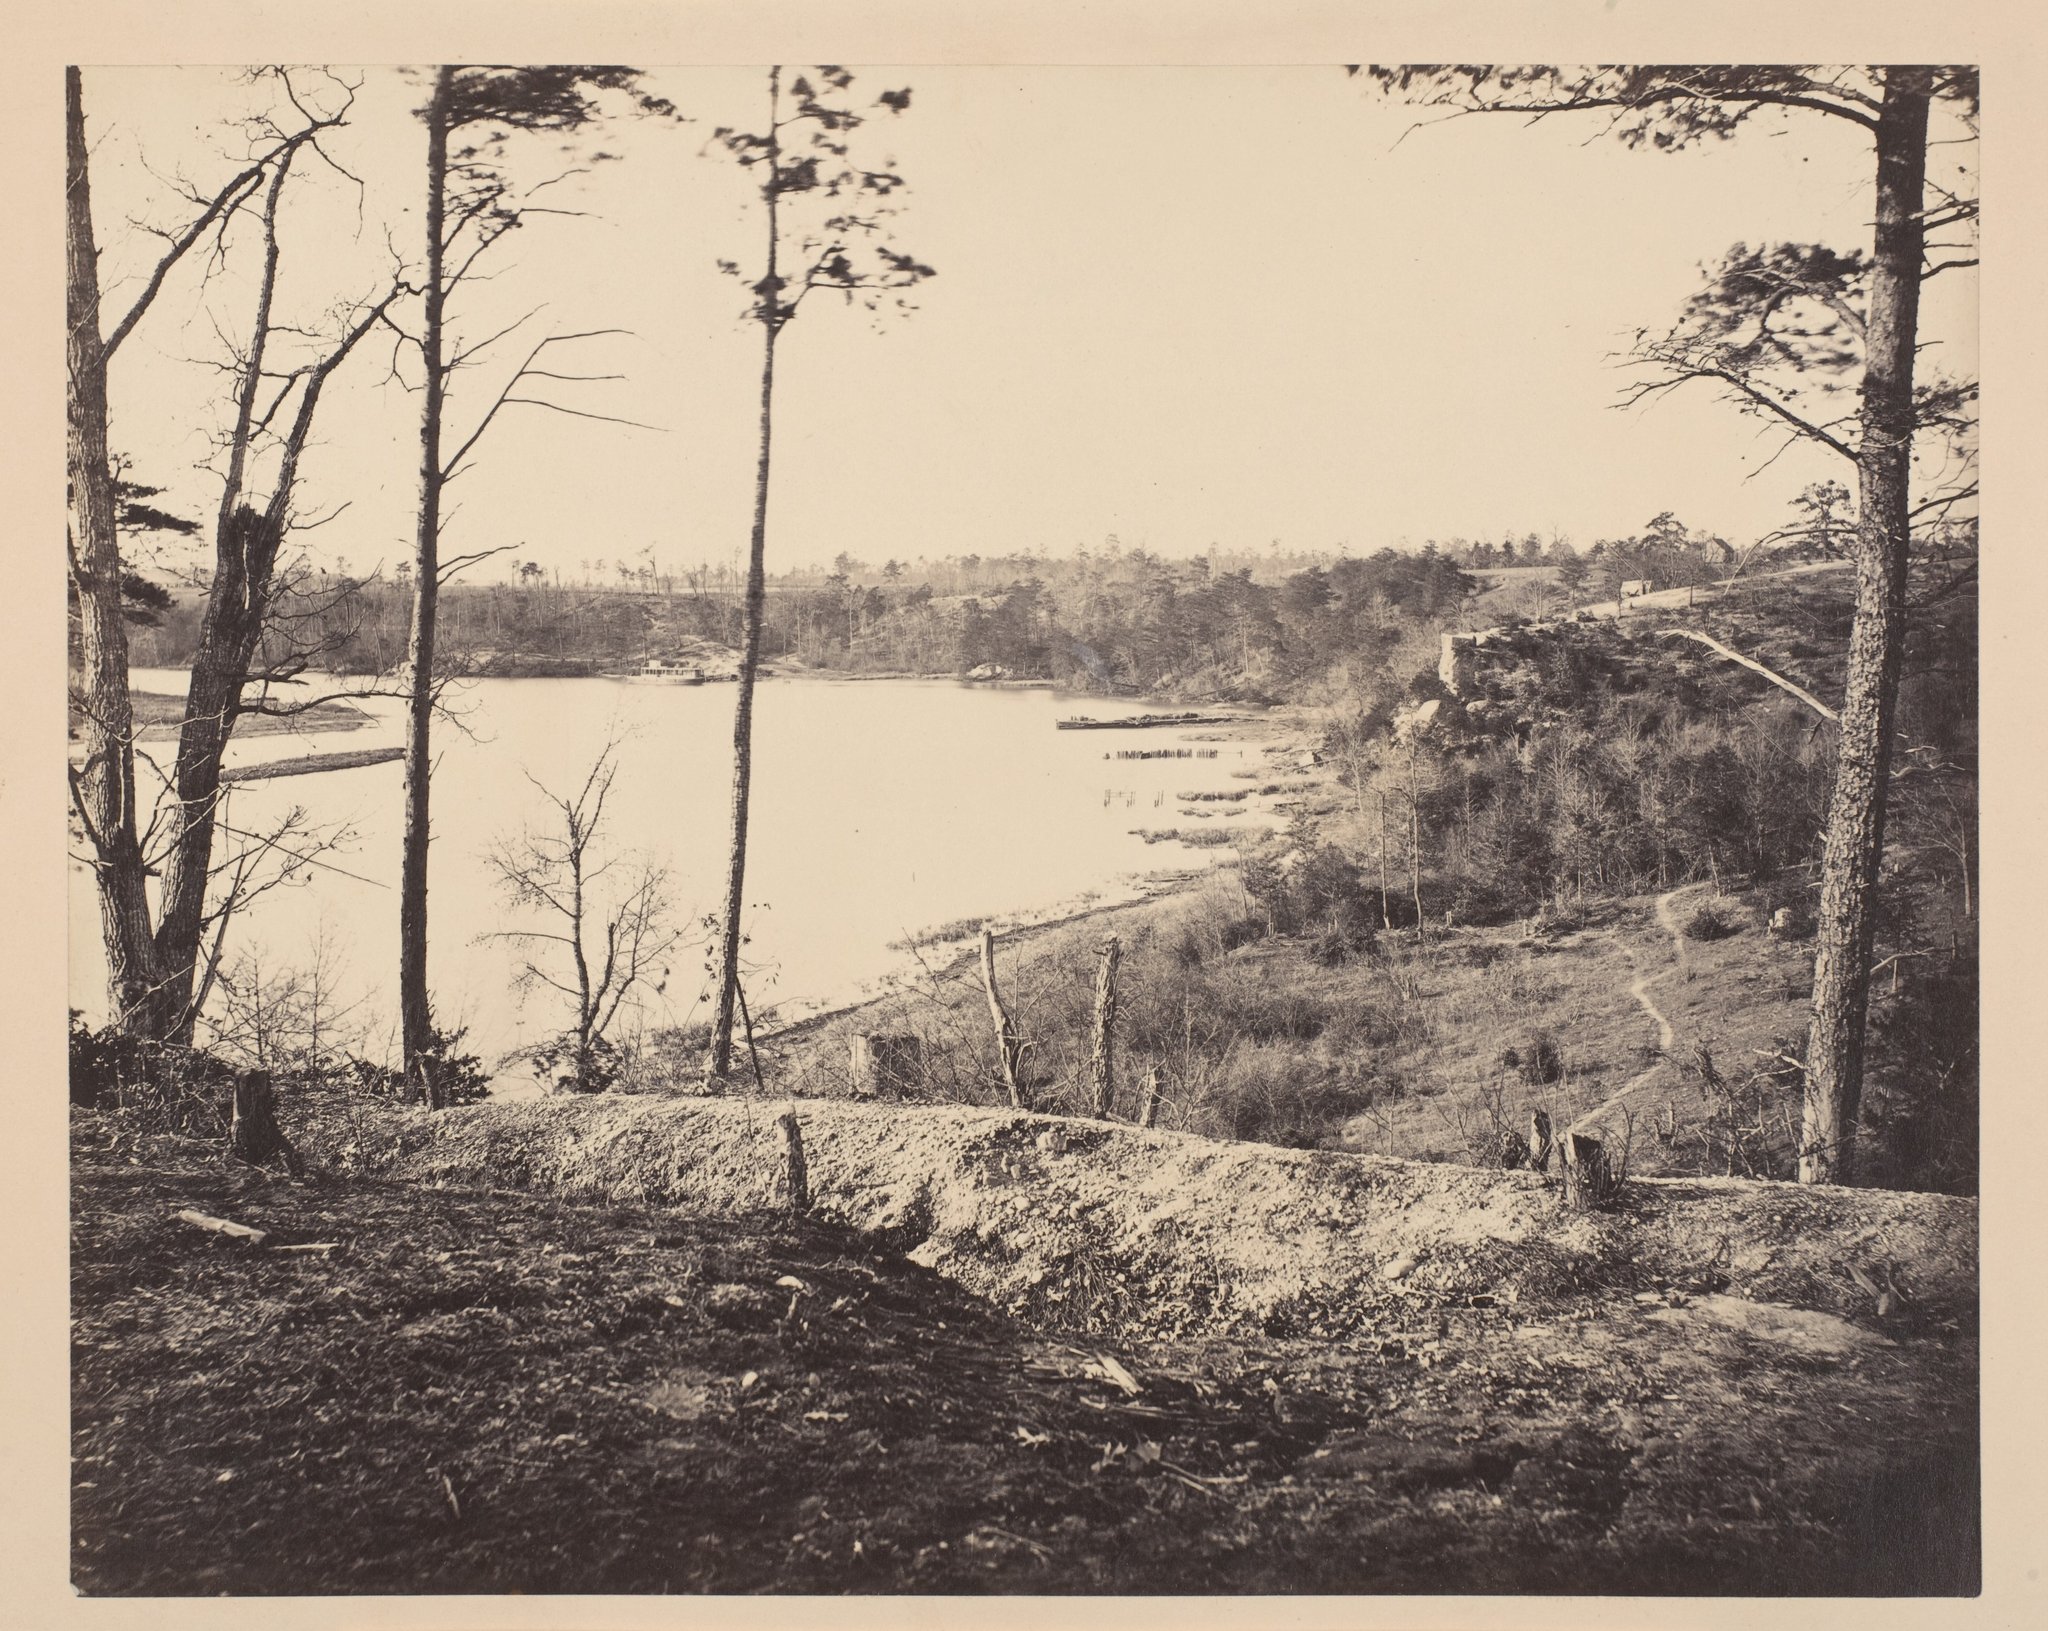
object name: photograph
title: [Civil War View]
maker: thomas c. roche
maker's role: artist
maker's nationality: american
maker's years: 1826-1895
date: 1860-1869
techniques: albumen silver print, glass negative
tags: american civil war,landscapes